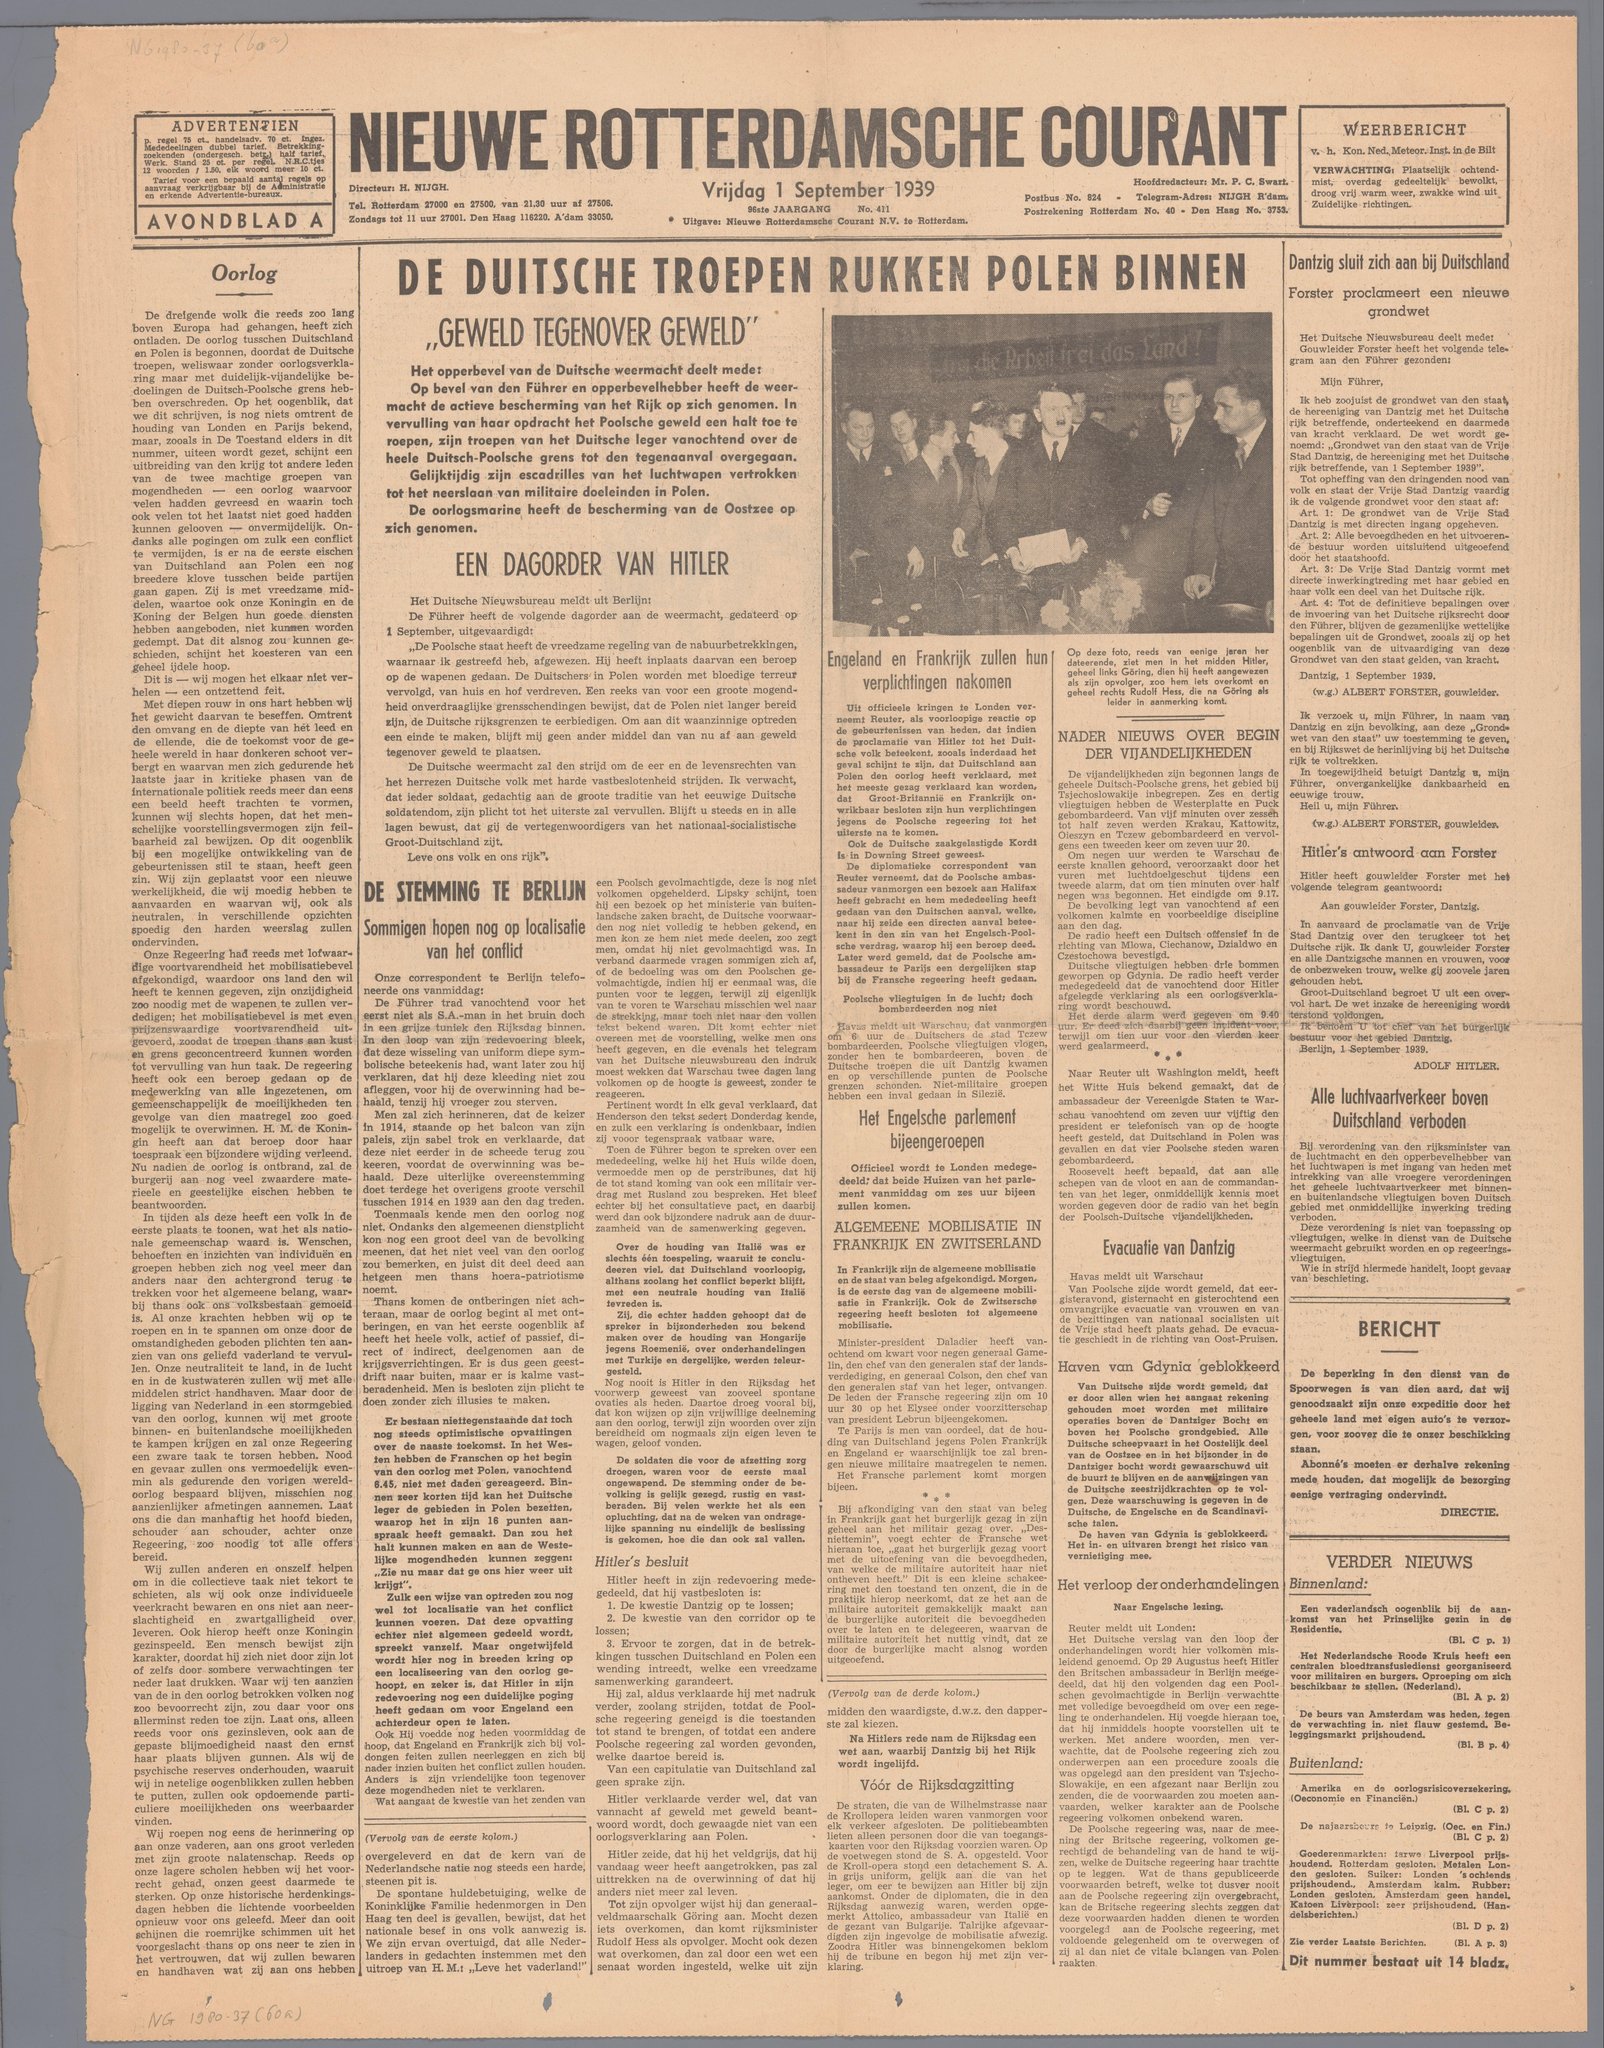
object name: newspaper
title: Nieuwe Rotterdamsche Courant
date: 1939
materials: paper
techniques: printing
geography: rotterdam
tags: poland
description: Krant over de duitse invasie in Polen, p. 1 & 2 van nr. 411, 96ste jaargang van de NRC.